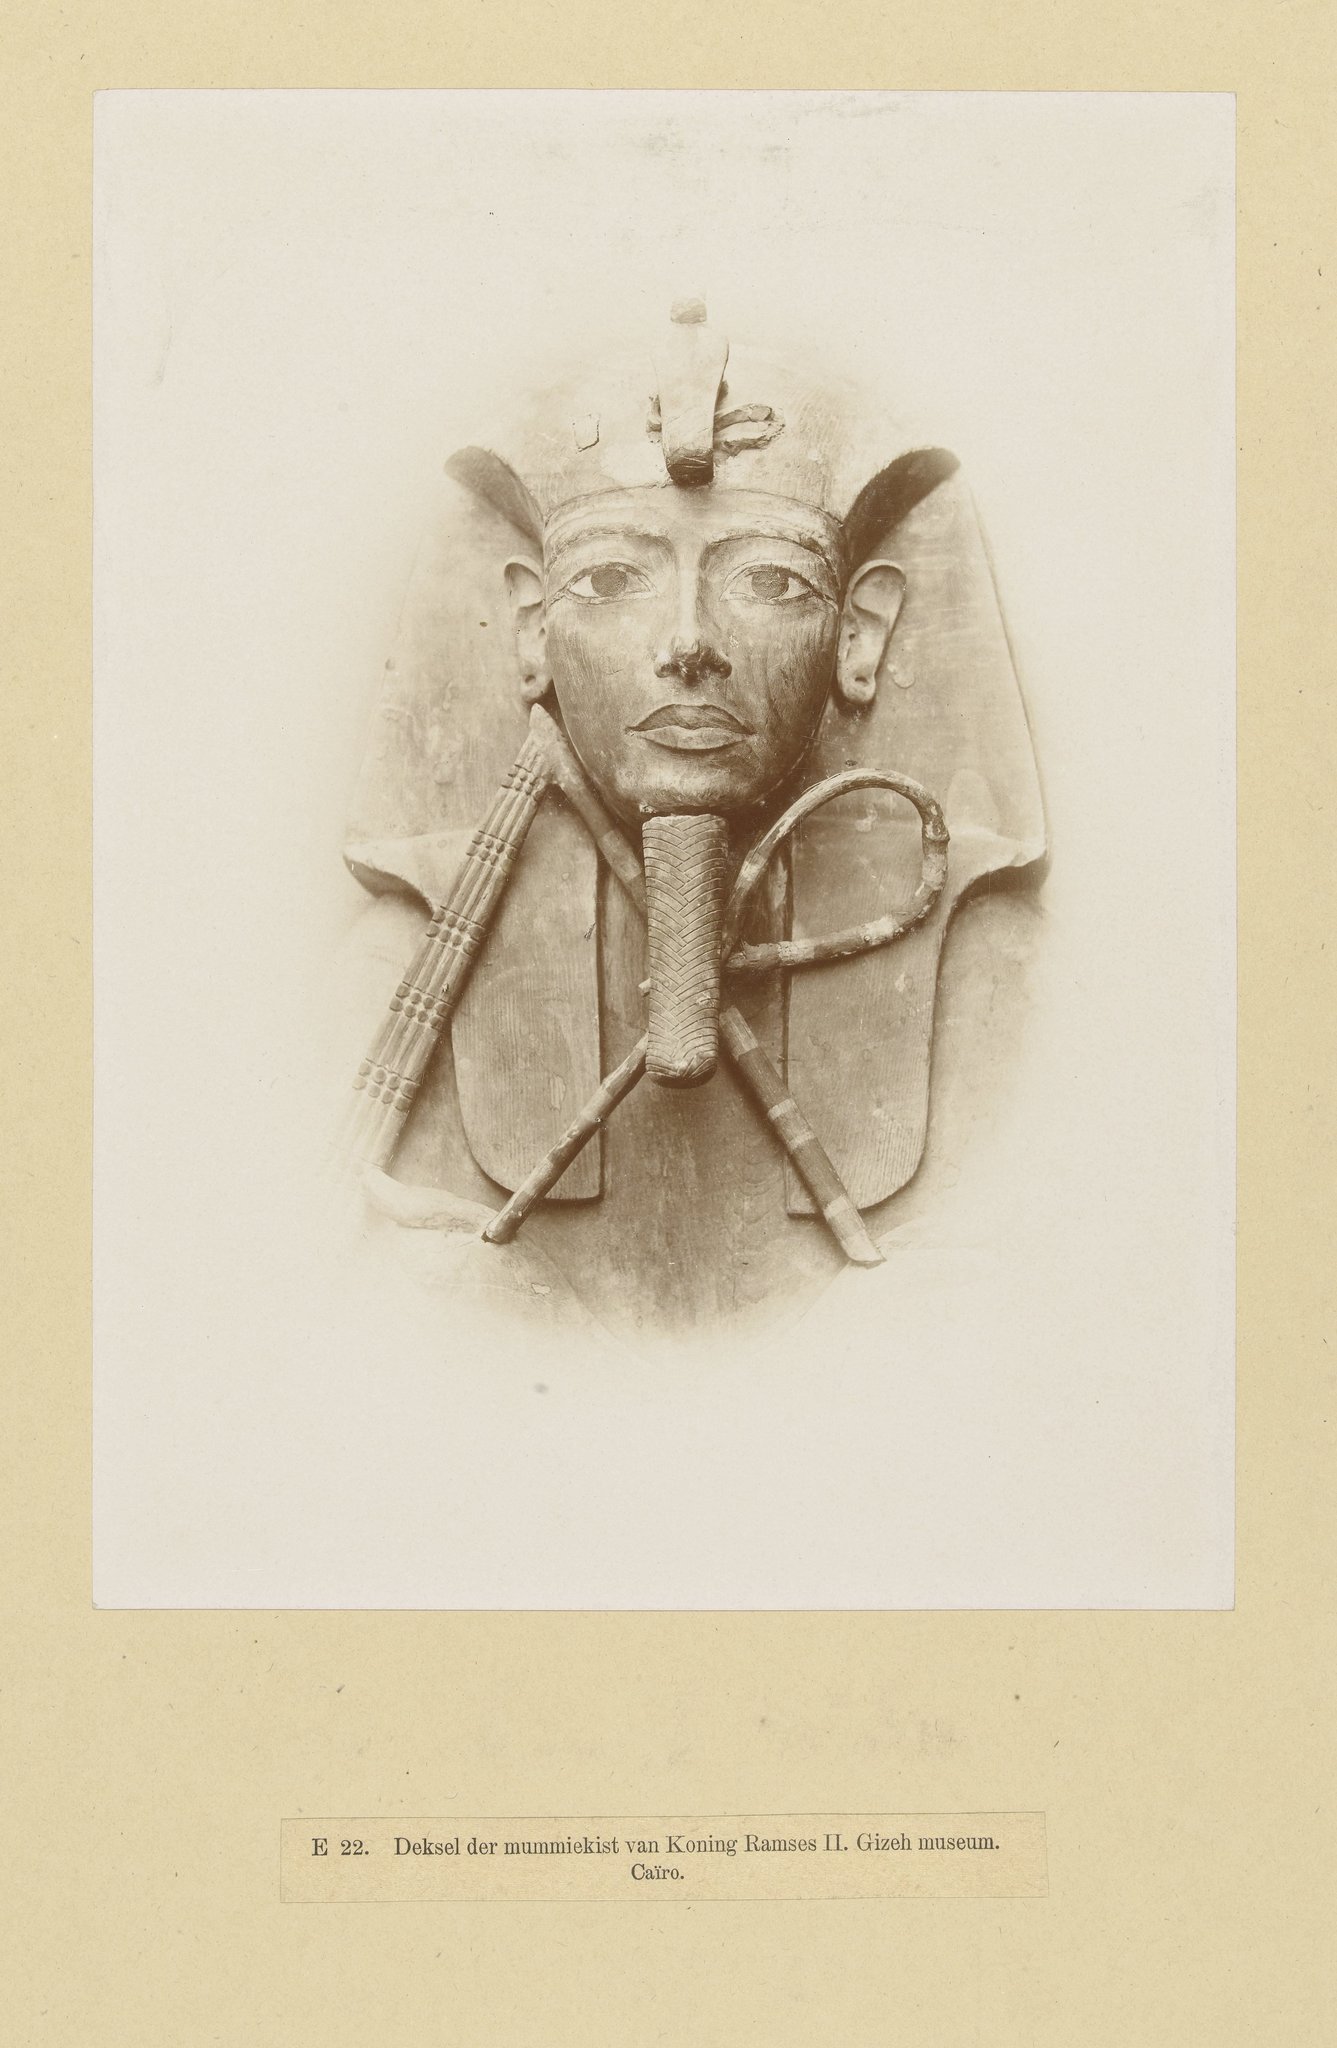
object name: photograph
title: E 22. Deksel der mummiekist van Koning Ramses II. Gizeh museum. Caïro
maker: Anonymous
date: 1890-1895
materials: paper, cardboard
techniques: collodion silver print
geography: cairo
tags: lid of sarcophagus, king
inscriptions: stamp: ‘Gemeentelijke bibliotheek/ Rotterdam’, check stamp: ‘Bristol/ L.M.’, title: ‘E 22. Deksel der mummiekist van Koning Ramses II. Gizeh museum./ Caïro.’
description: Onderdeel van een groep door fotograaf Richard Polak op reis verzamelde foto’s. Deze foto is samen met andere op zijn reizen verzamelde foto's tentoongesteld bij de Rotterdamsche Kunstkring (1895), Arti en Amicitiae te Amsterdam (1897-1898?) en Societeit 't Collegie te Kampen (datum vooralsnog onbekend).